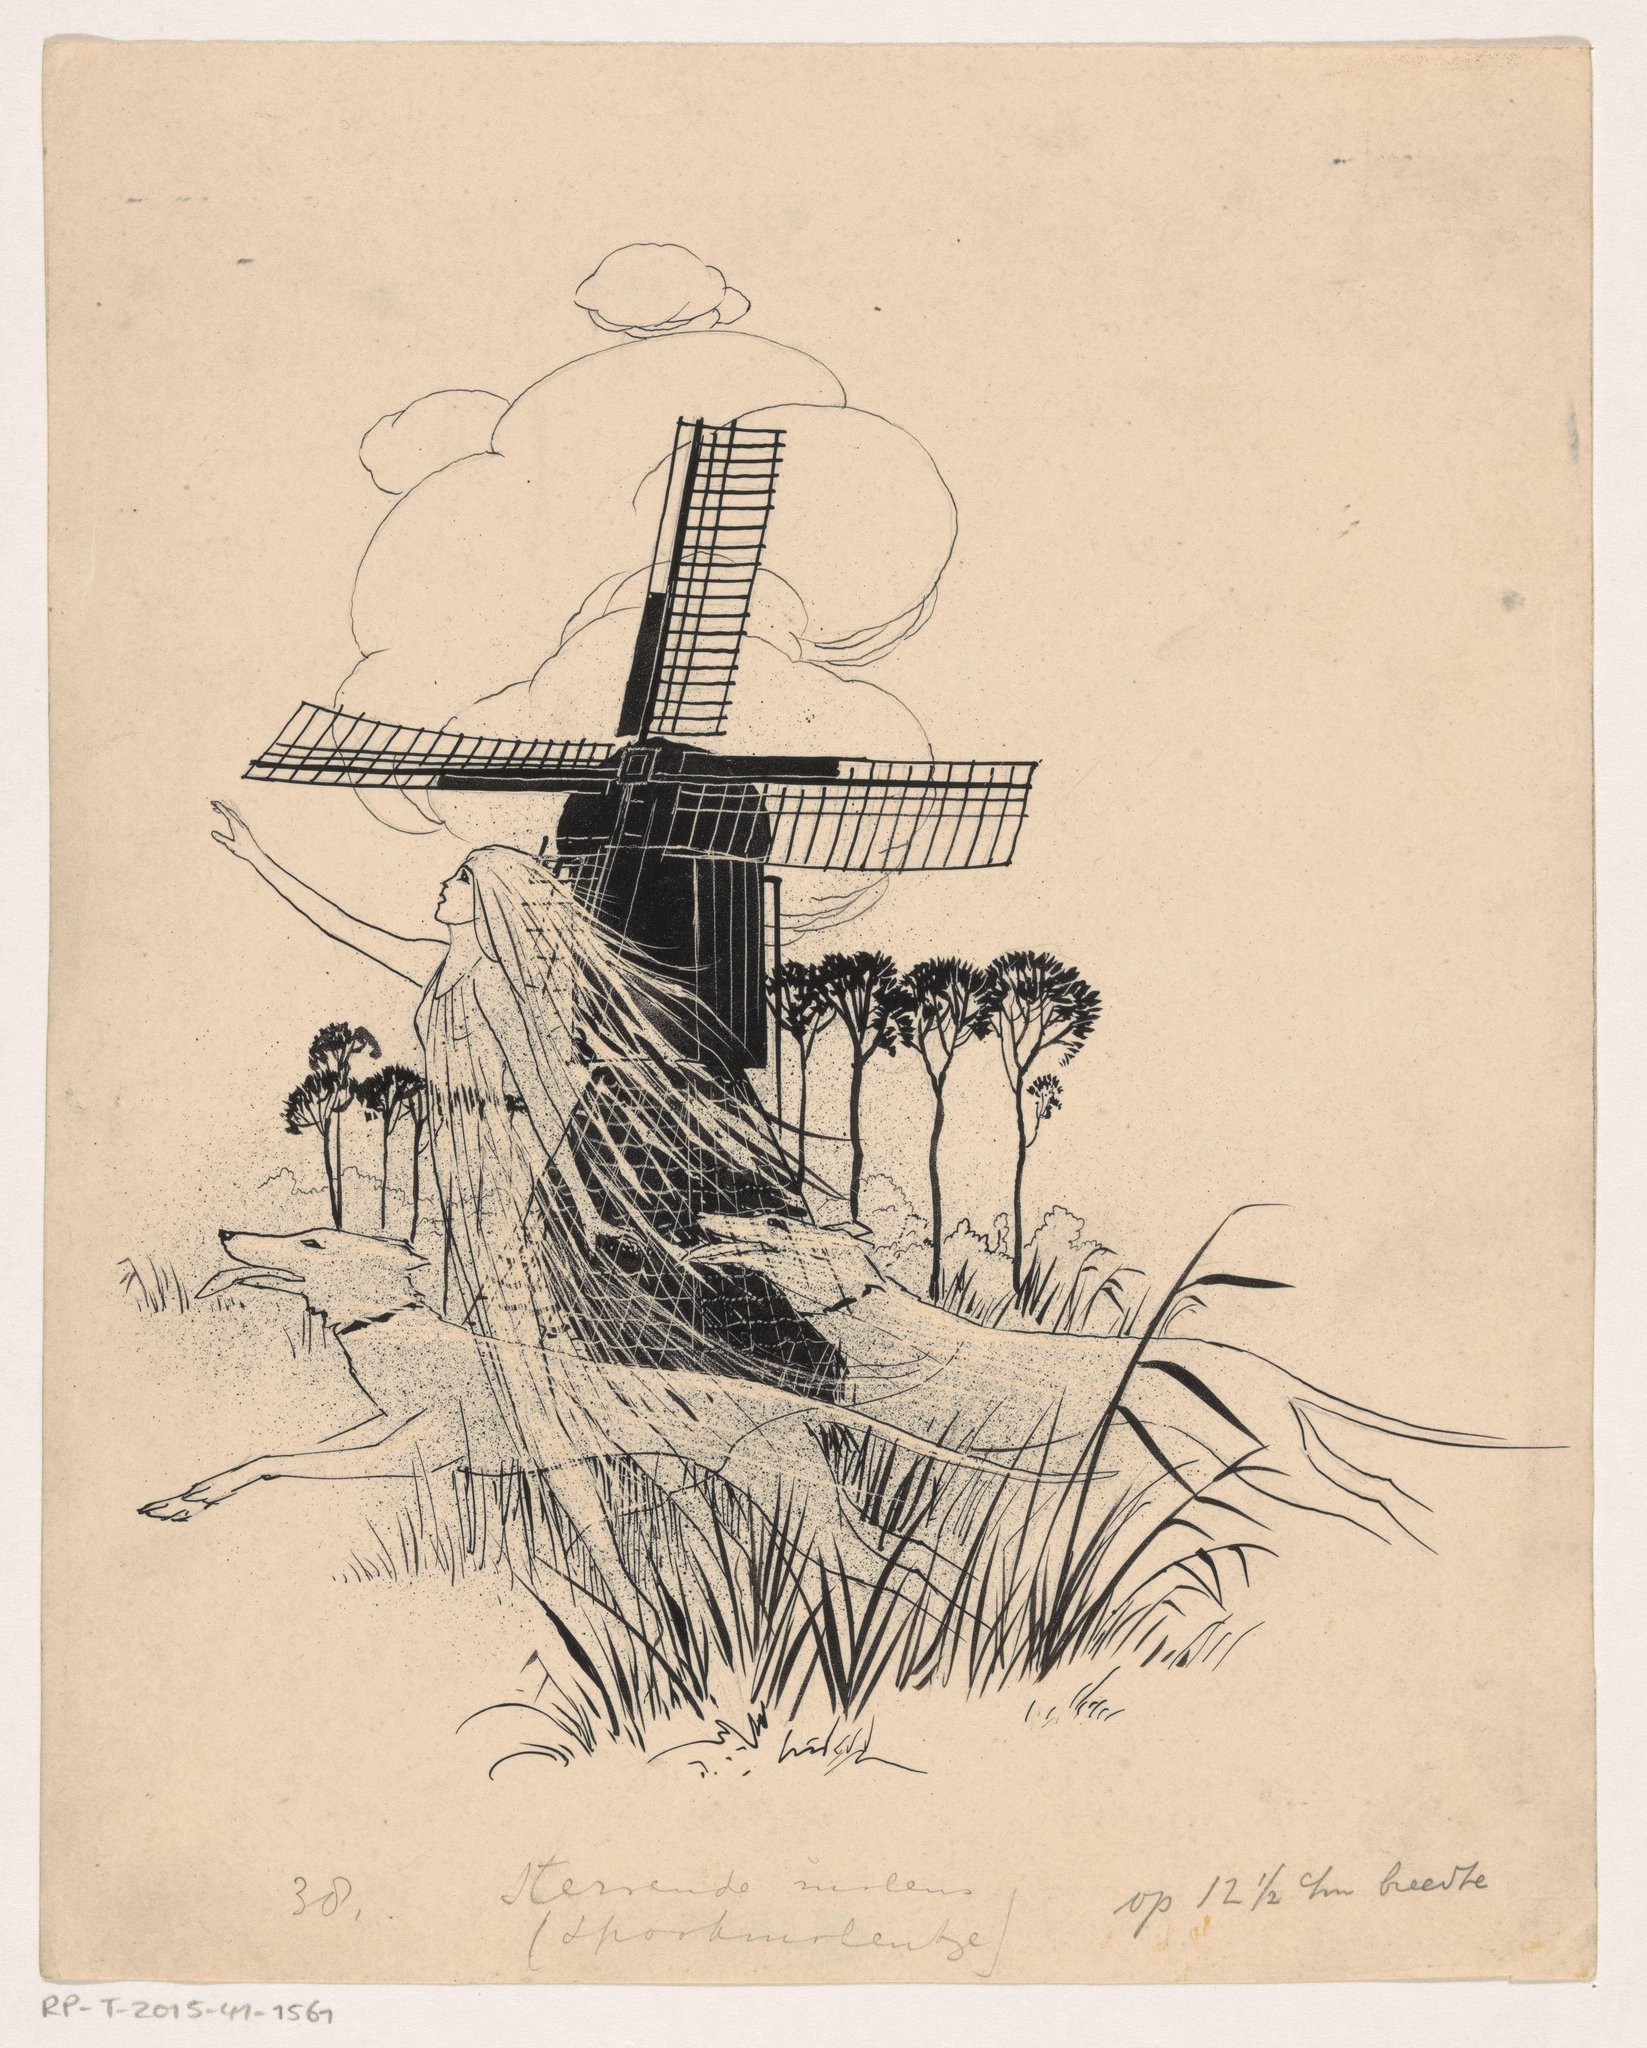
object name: drawing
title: Schim van een meisje en twee honden bij een molen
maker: henri verstijnen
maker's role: draughtsman, print maker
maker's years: 1882-1940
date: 1892-1940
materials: ink, paper, pencil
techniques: brush, pen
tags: spirit, ghost, windmill, dog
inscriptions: annotation: ‘38. Stervende molens/ (spookmolentje)’, collector's mark: Lugt 2228, :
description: Een schim van een meisje gekleed in een lange jurk zweeft met uitgestrekte arm voorbij een molen. Twee honden rennen met haar mee.